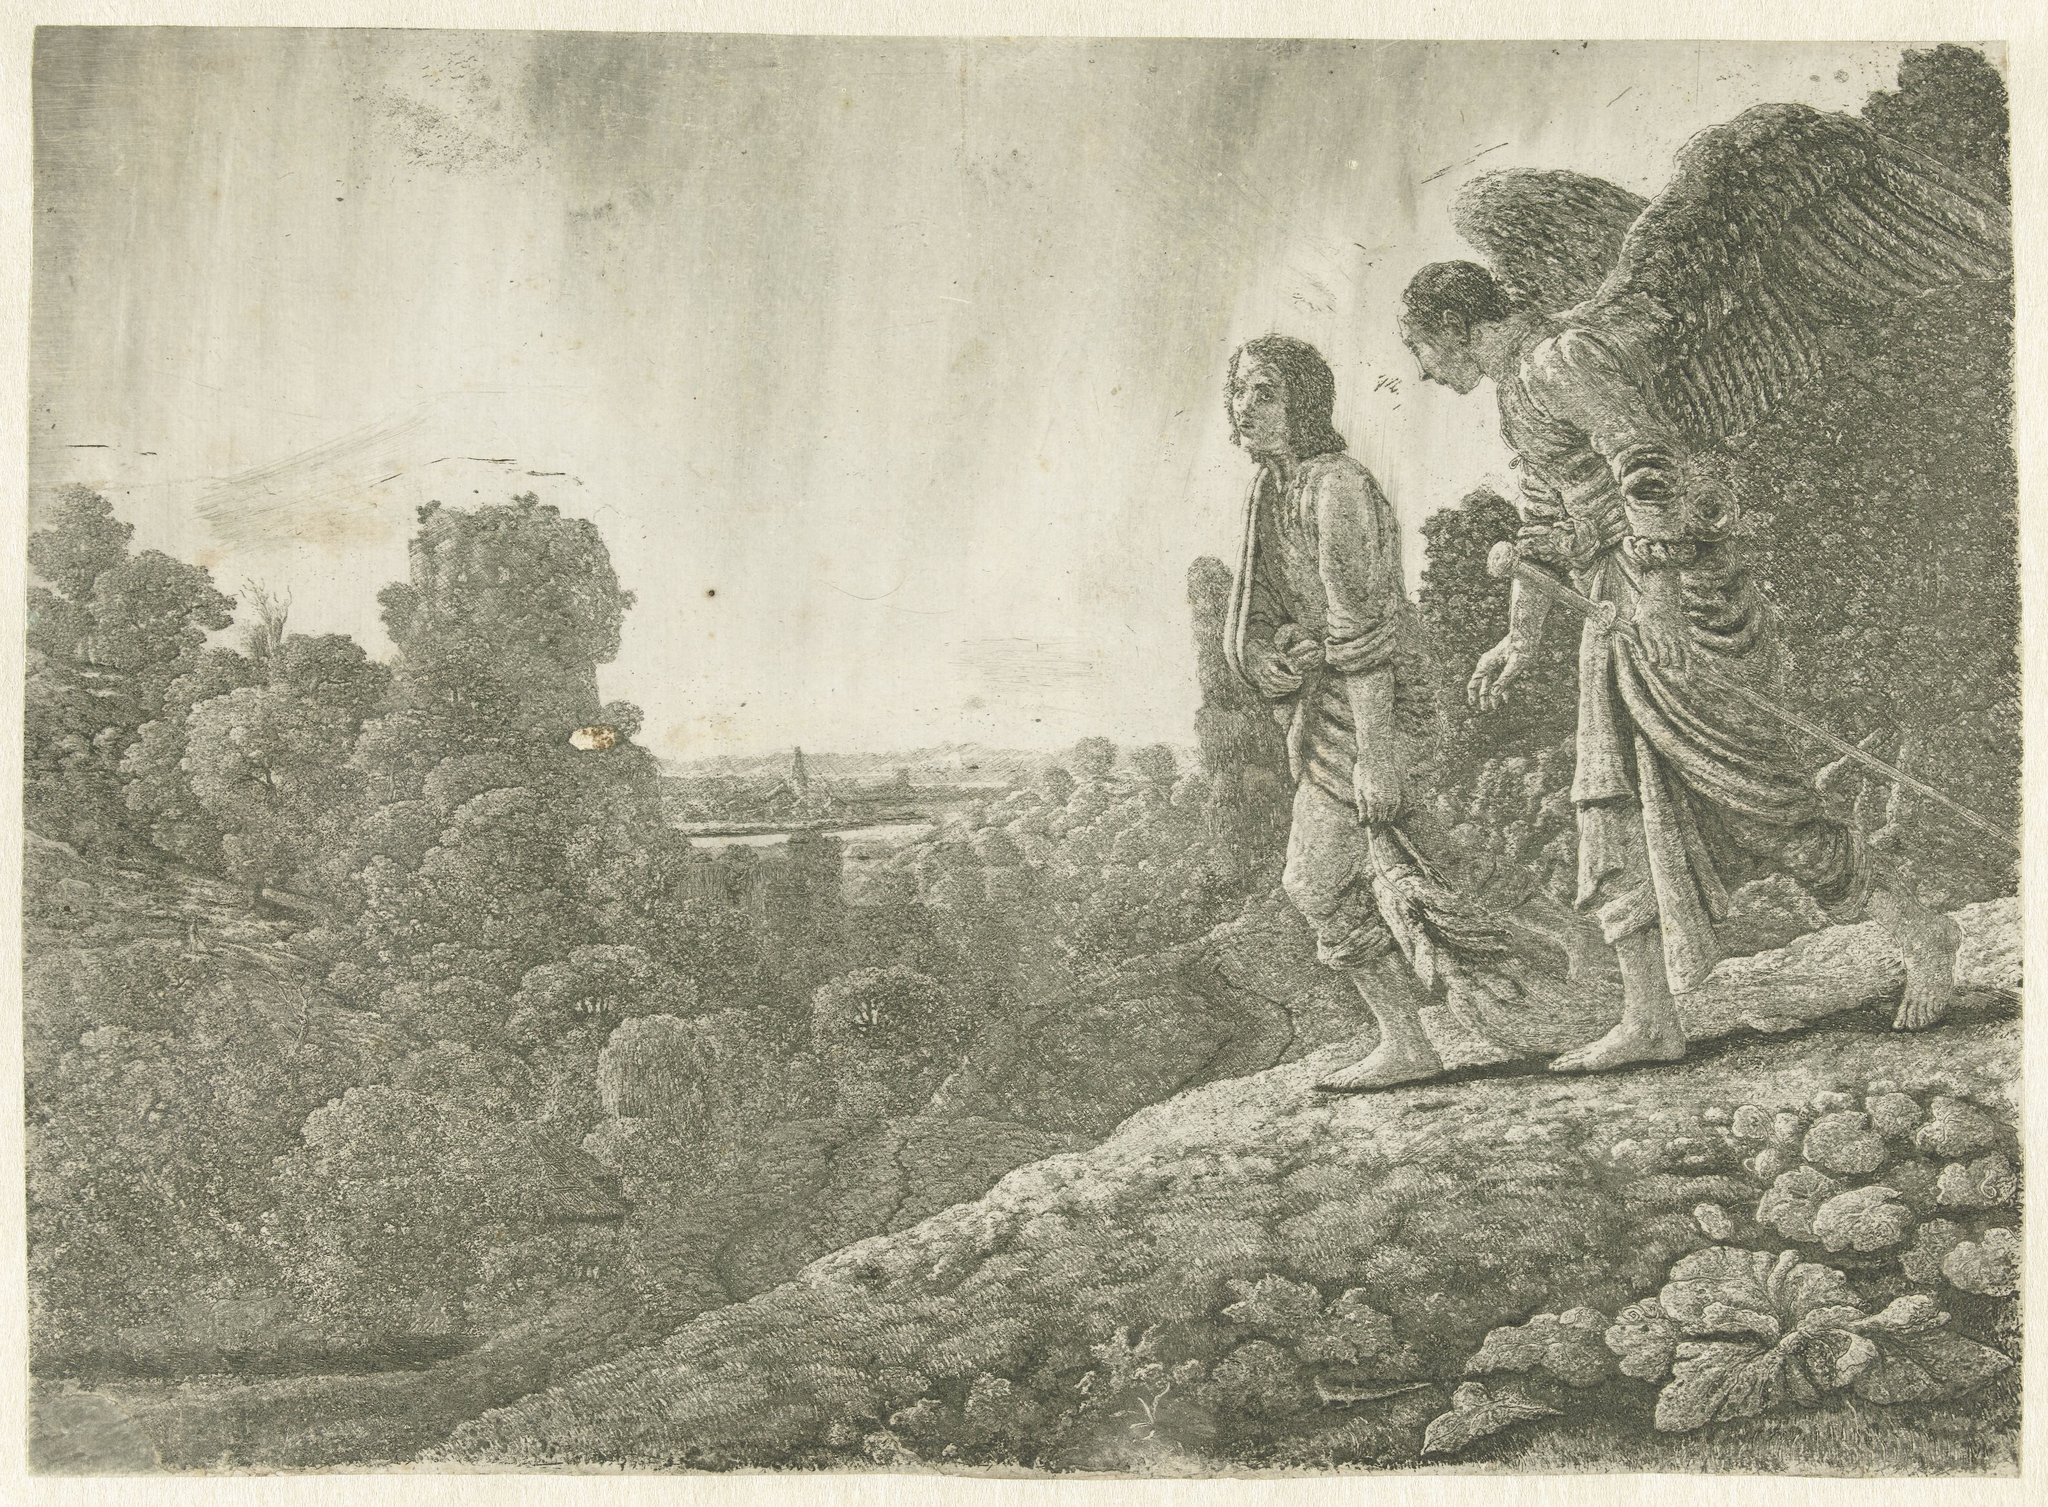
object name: print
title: Tobias and the Angel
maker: hercules segers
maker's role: draughtsman, painter, print maker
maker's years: 1589-1640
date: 1630-1633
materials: paper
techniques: etching, intaglio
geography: amsterdam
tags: tobias and the angel raphael continue their journey; usually tobias carrying the fish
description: On the basis of the watermark in the paper used for this etching, it could be dated to around 1630–1633. It must have been one of Segers’ last prints, and given the representation and its sensitive execution also his most ambitious one.